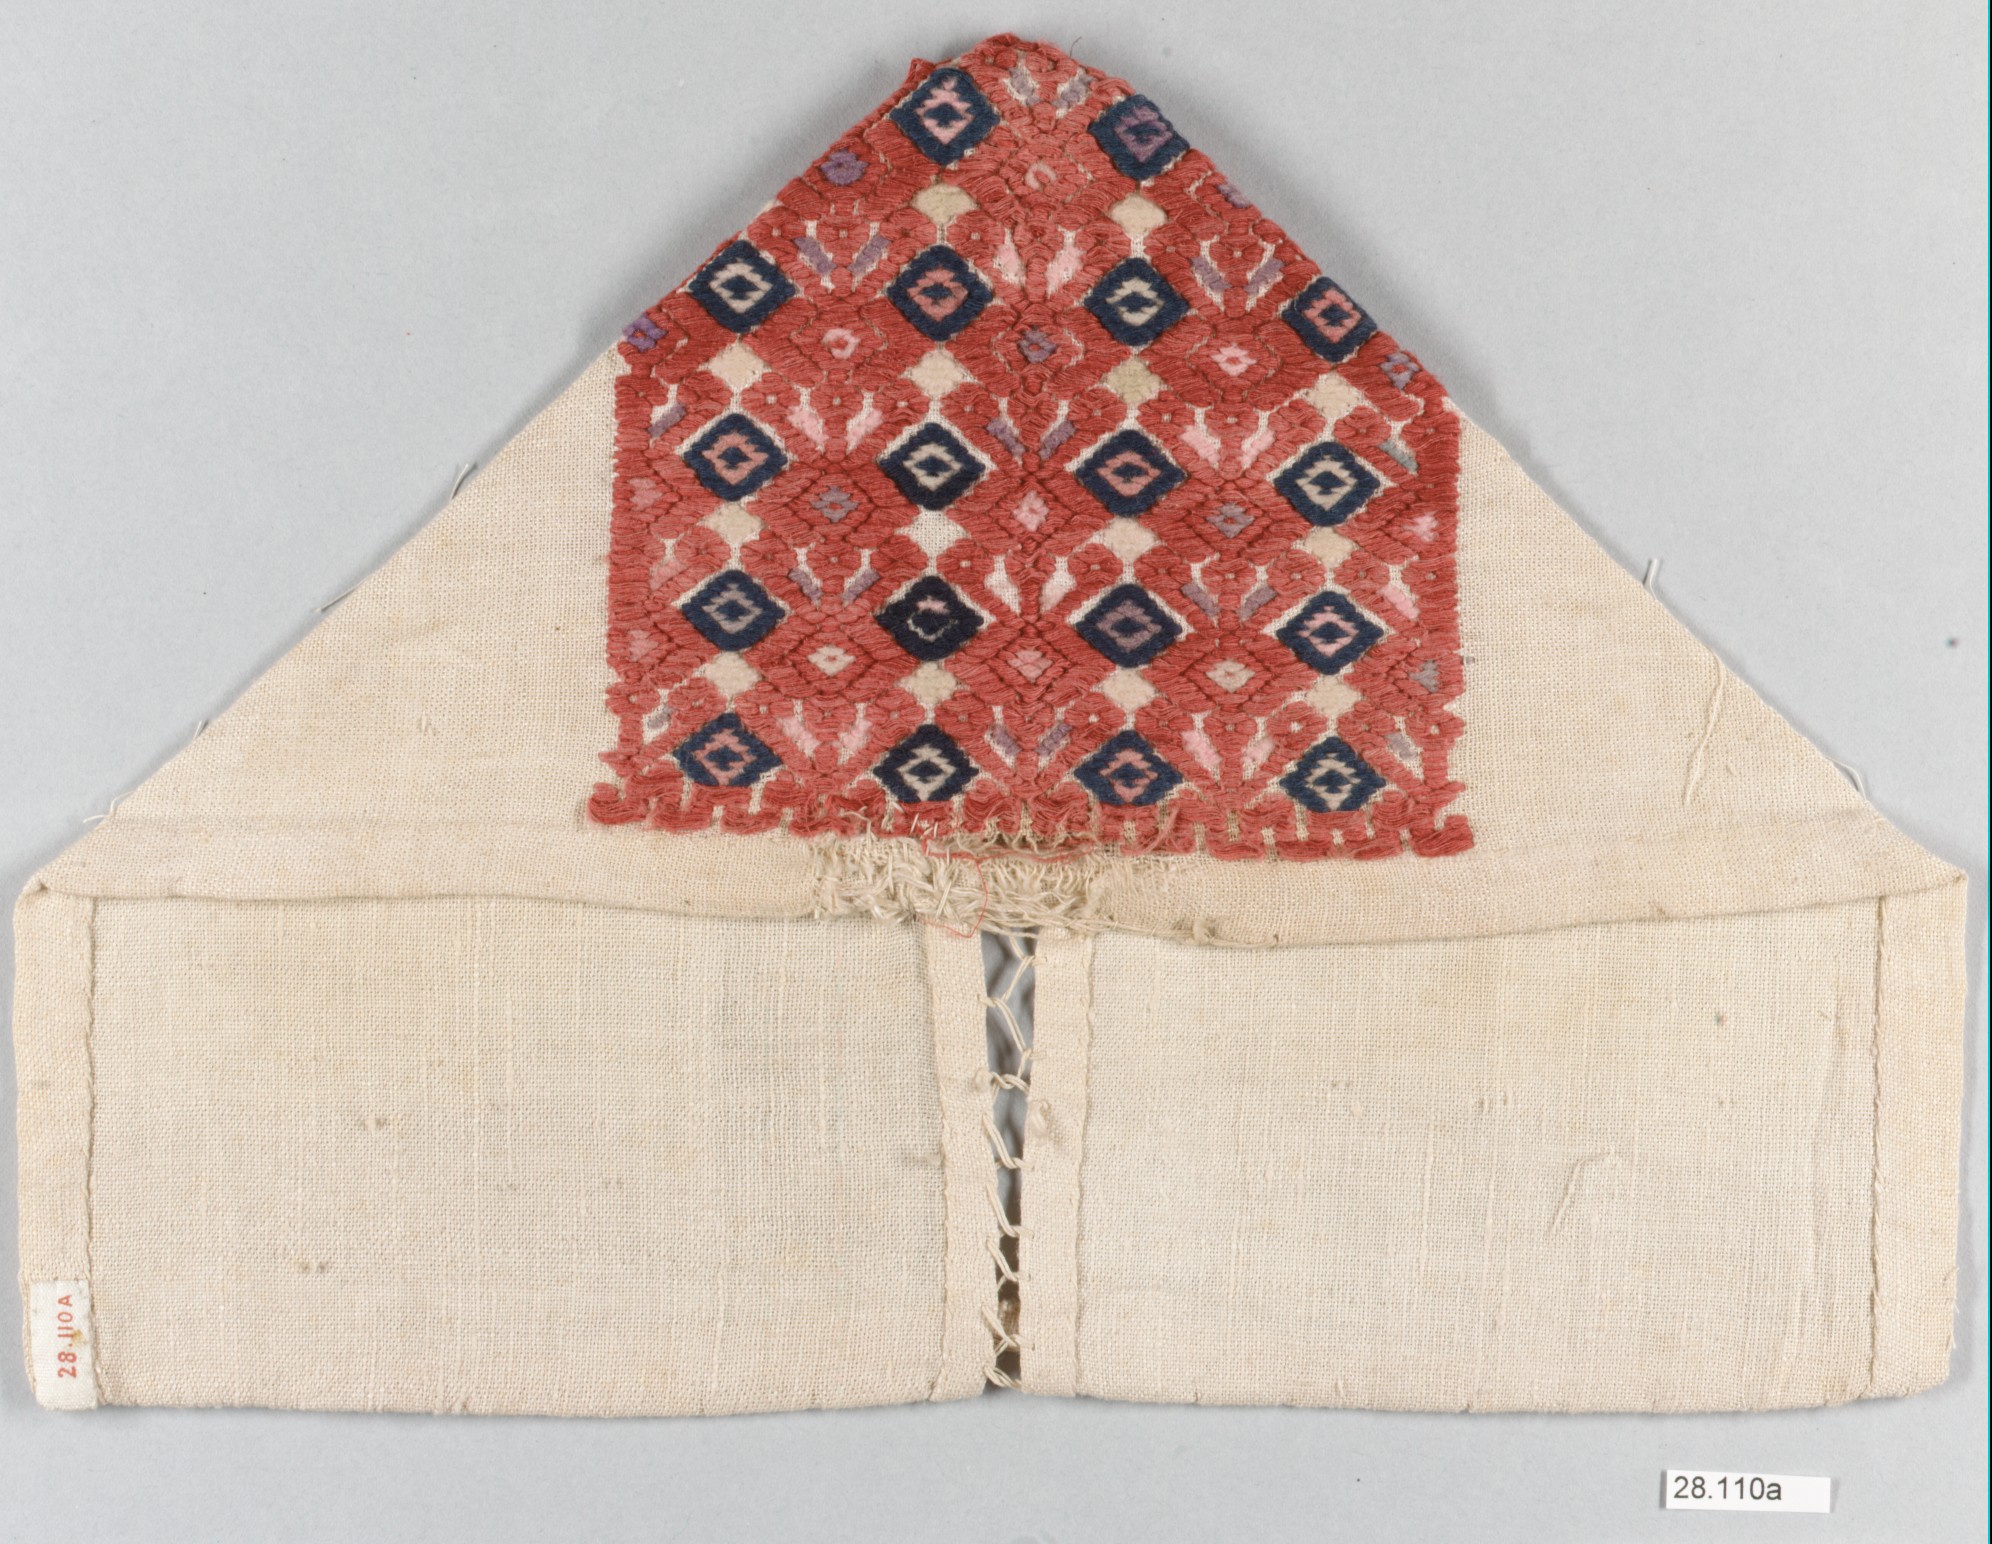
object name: cap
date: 1801-1900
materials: linen, wool